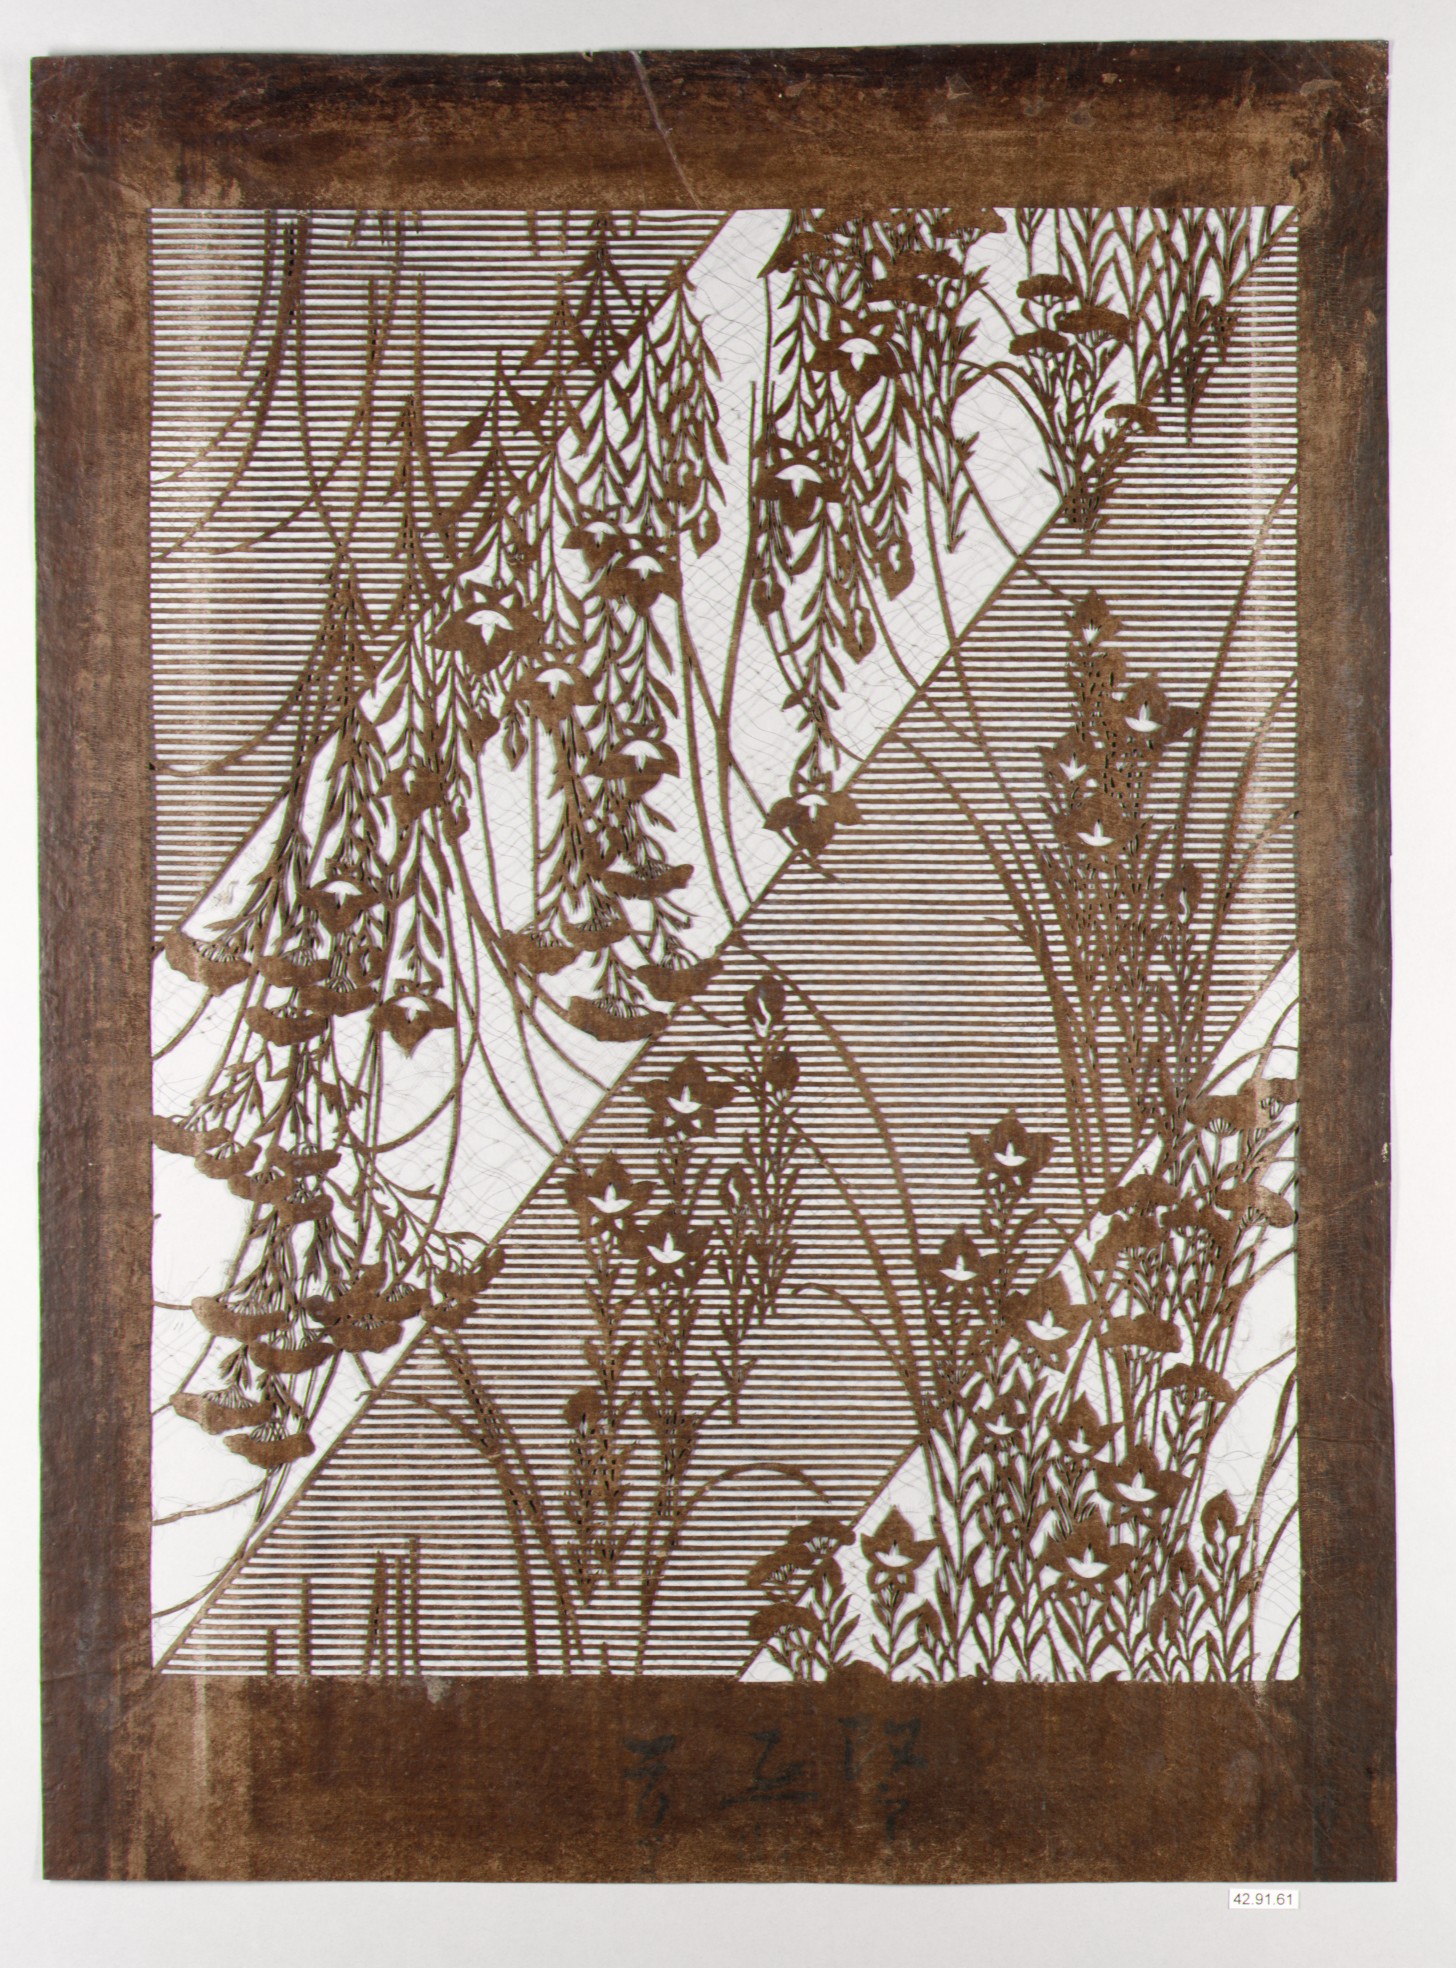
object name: stencil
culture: japanese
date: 1801-1900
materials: paper, silk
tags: plants